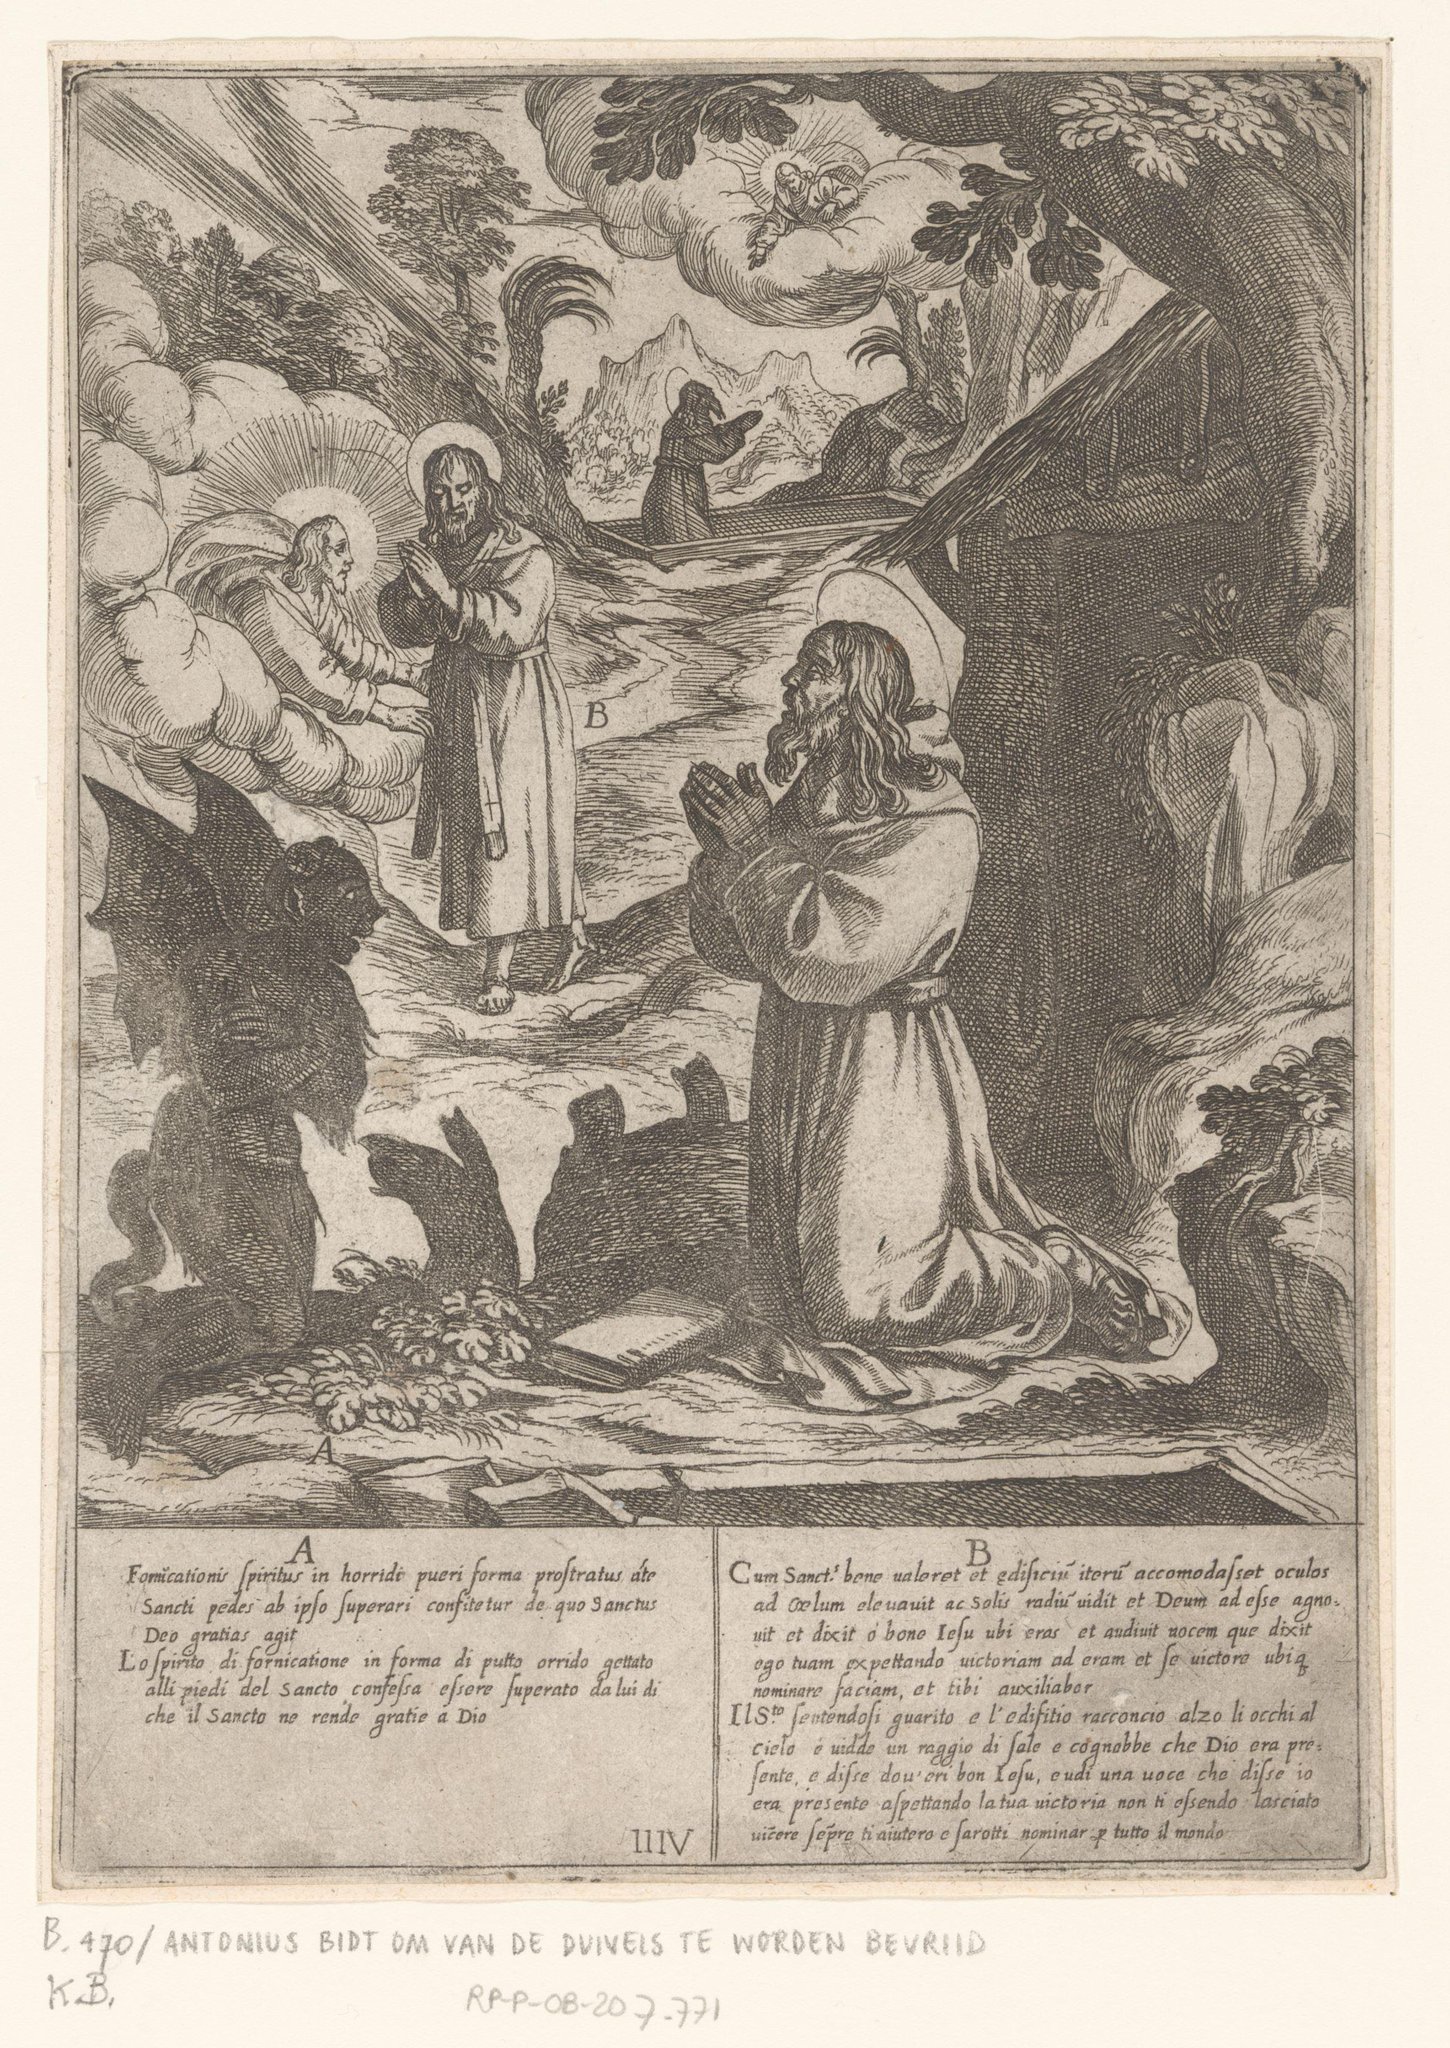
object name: print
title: Het leven van de heilige Antonius de Grote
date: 1598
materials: paper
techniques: etching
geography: italy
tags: devil(s) and demons, the erotic visions of st. antony abbot: he is tempted by (naked) women, but drives them off by praying, or by showing them a crucifix, the hermit antony abbot (antonius abbas) of egypt, also called the great; possible attributes: bell, book, t-shaped staff, flames, pig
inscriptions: collector's mark: Lugt 240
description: Deze prent maakt deel uit van een reeks van 27 prenten (+ titelprent) over het leven van de heilige Antonius, naar een frescocyclus in de S. Antonio Abbate in Rome door Giovanni Battista Lombardelli en Niccolò Circignani.